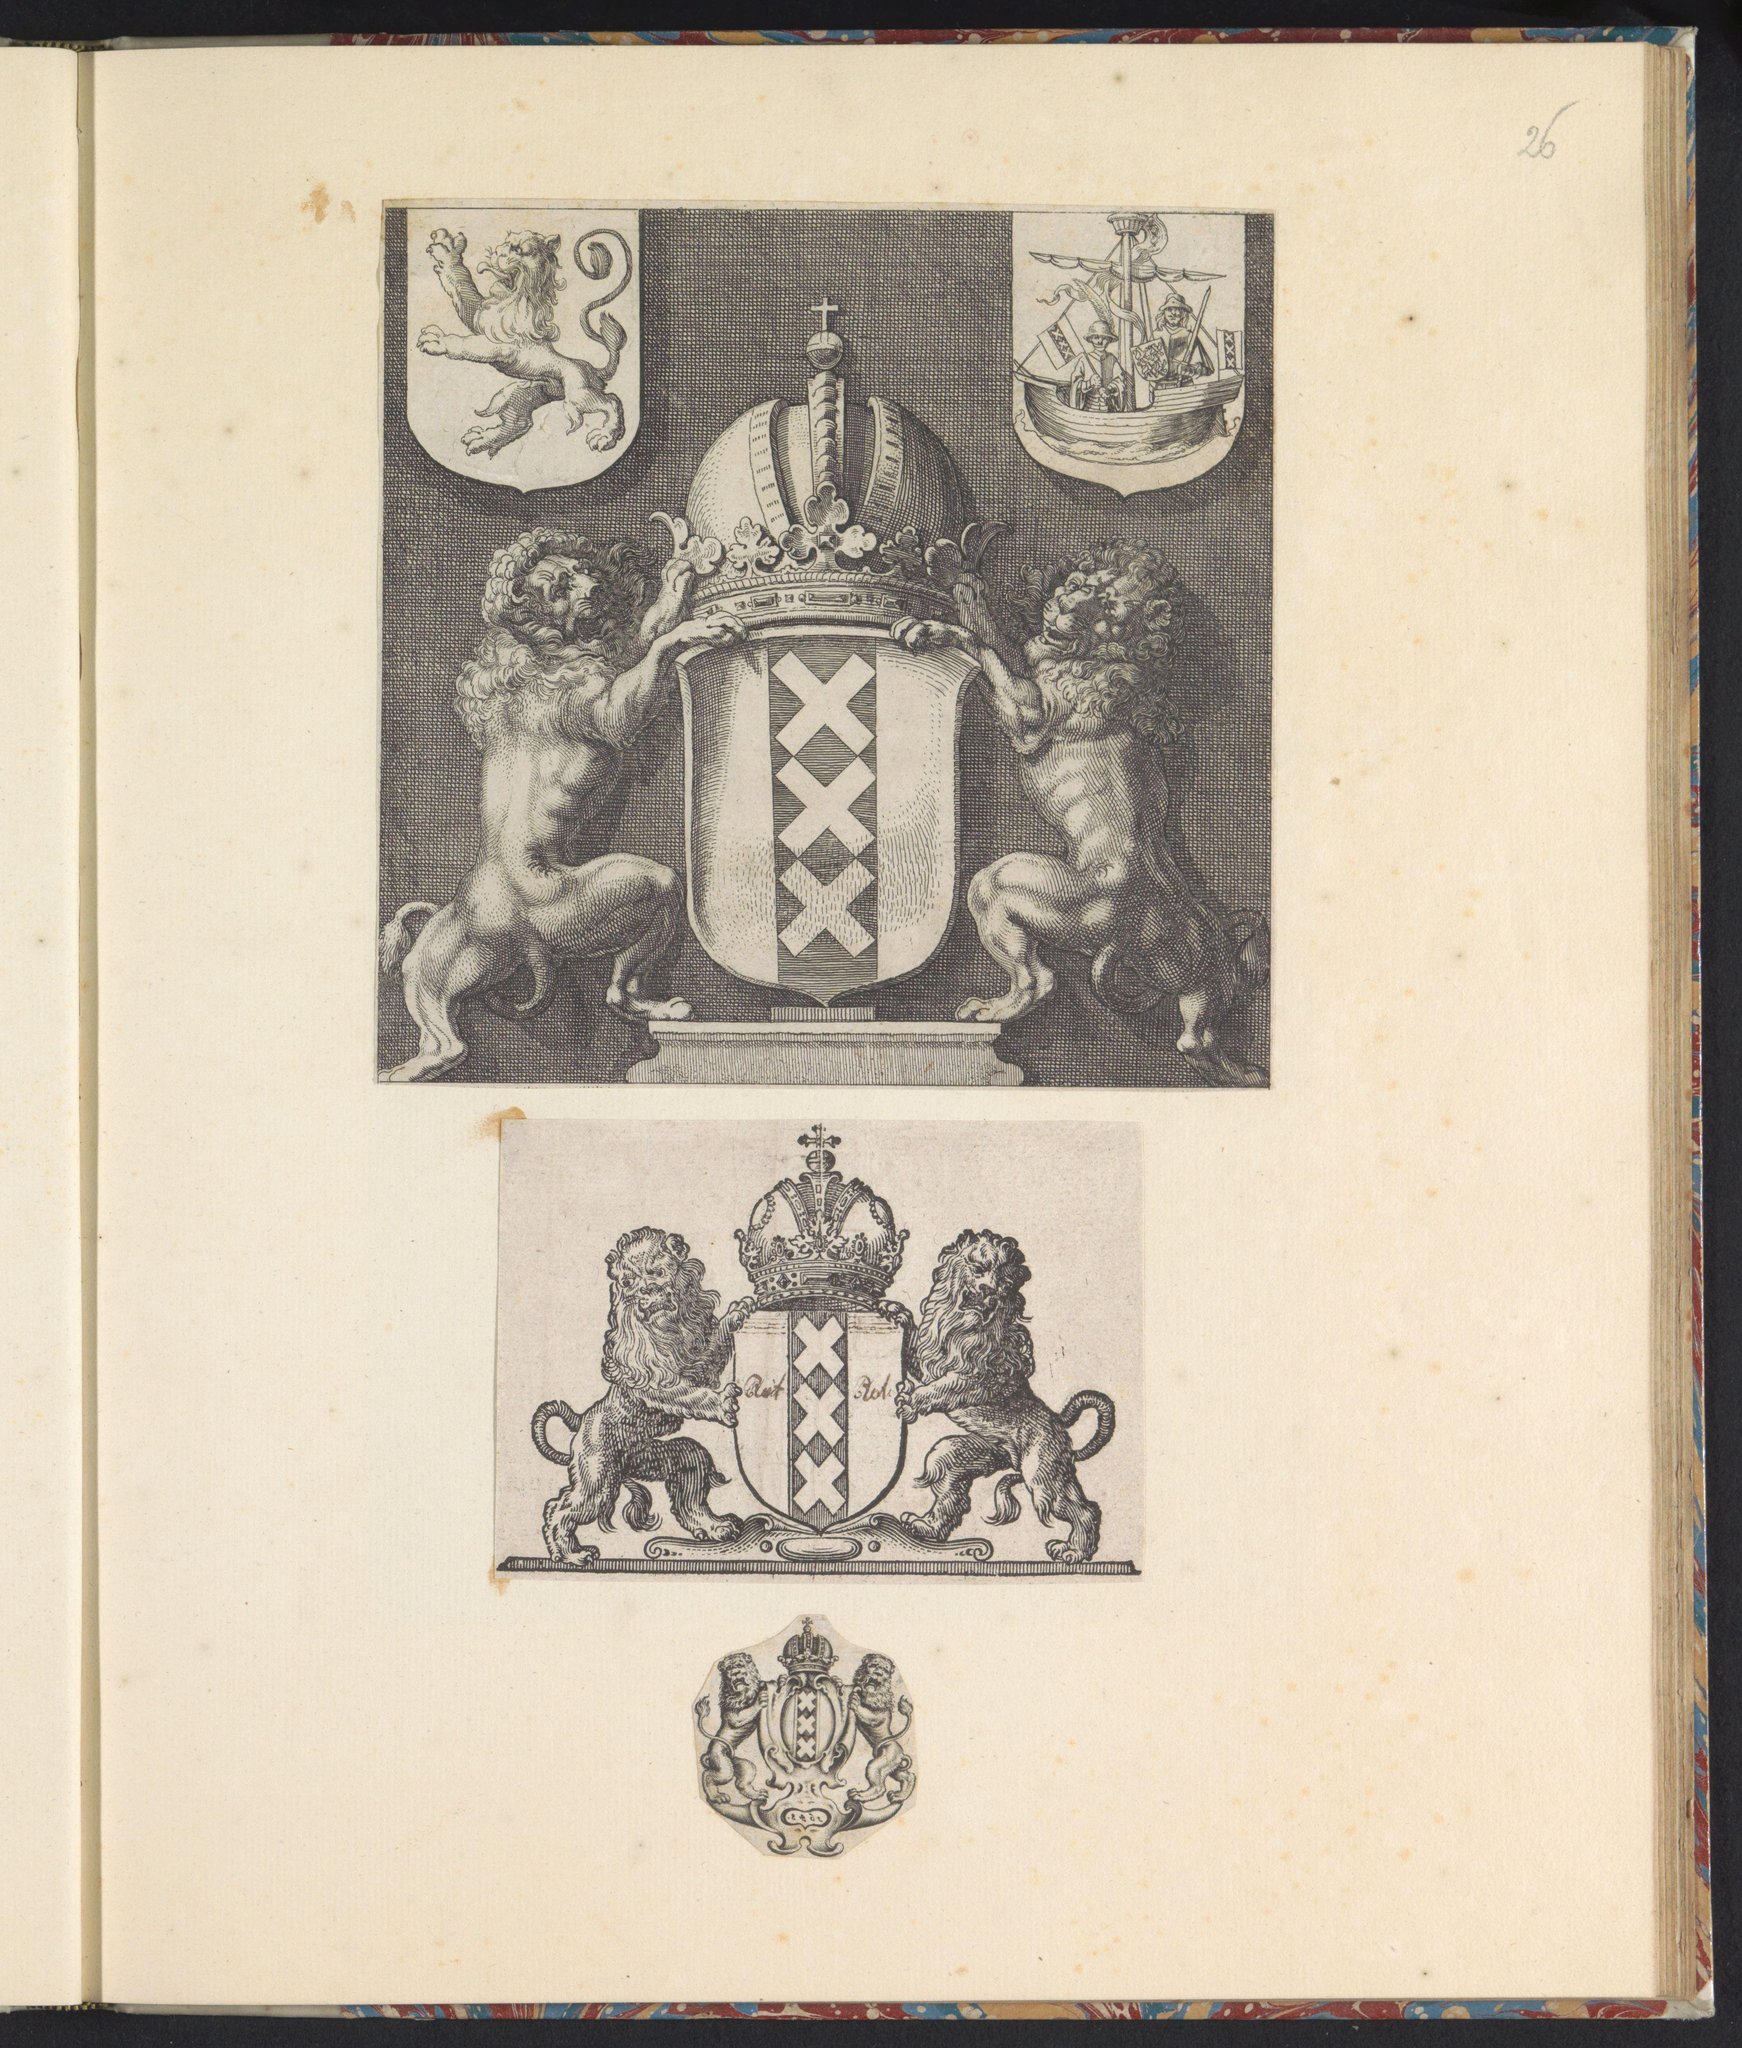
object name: album leaf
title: Drie keer het wapen van Amsterdam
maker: Anonymous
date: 1600-1699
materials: paper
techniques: engraving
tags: armorial bearing, heraldry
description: Drie voorstellingen op een albumblad. De prenten maken deel uit van een album.